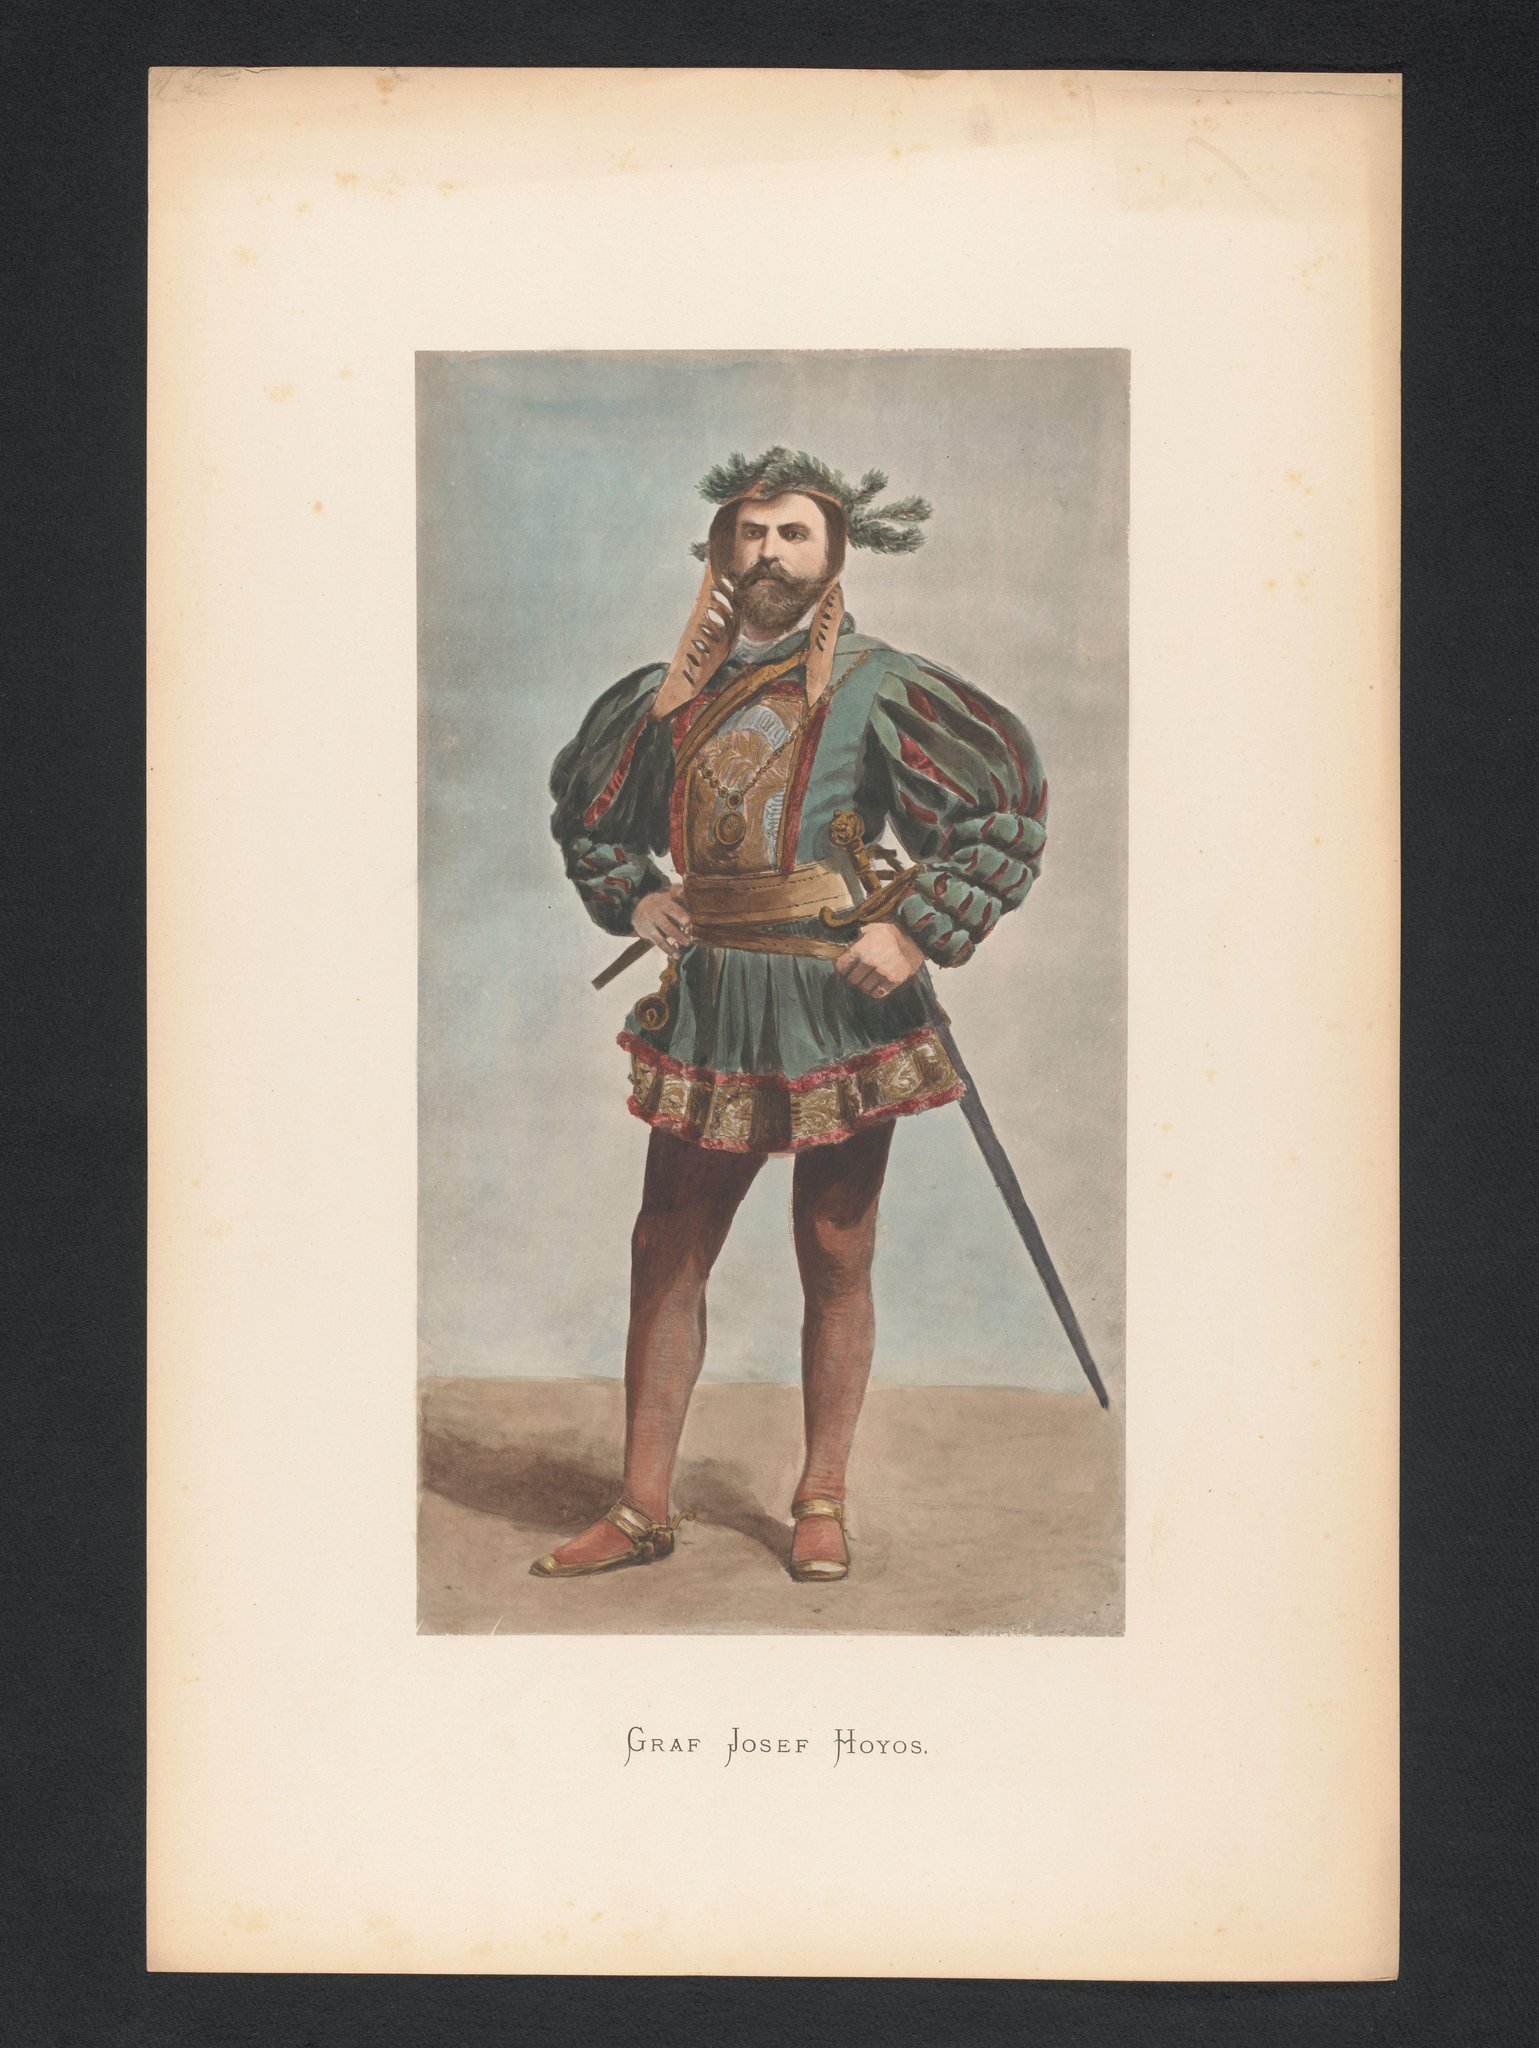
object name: photomechanical print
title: Graf Josef Hoyos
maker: Anonymous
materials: paper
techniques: photograph, hand coloring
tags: aristocracy; 'aristocratia' (ripa), historical persons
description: Deze prent maakt deel uit van een omslag met 86 prenten op 78 bladen en 11 tekstbladen.